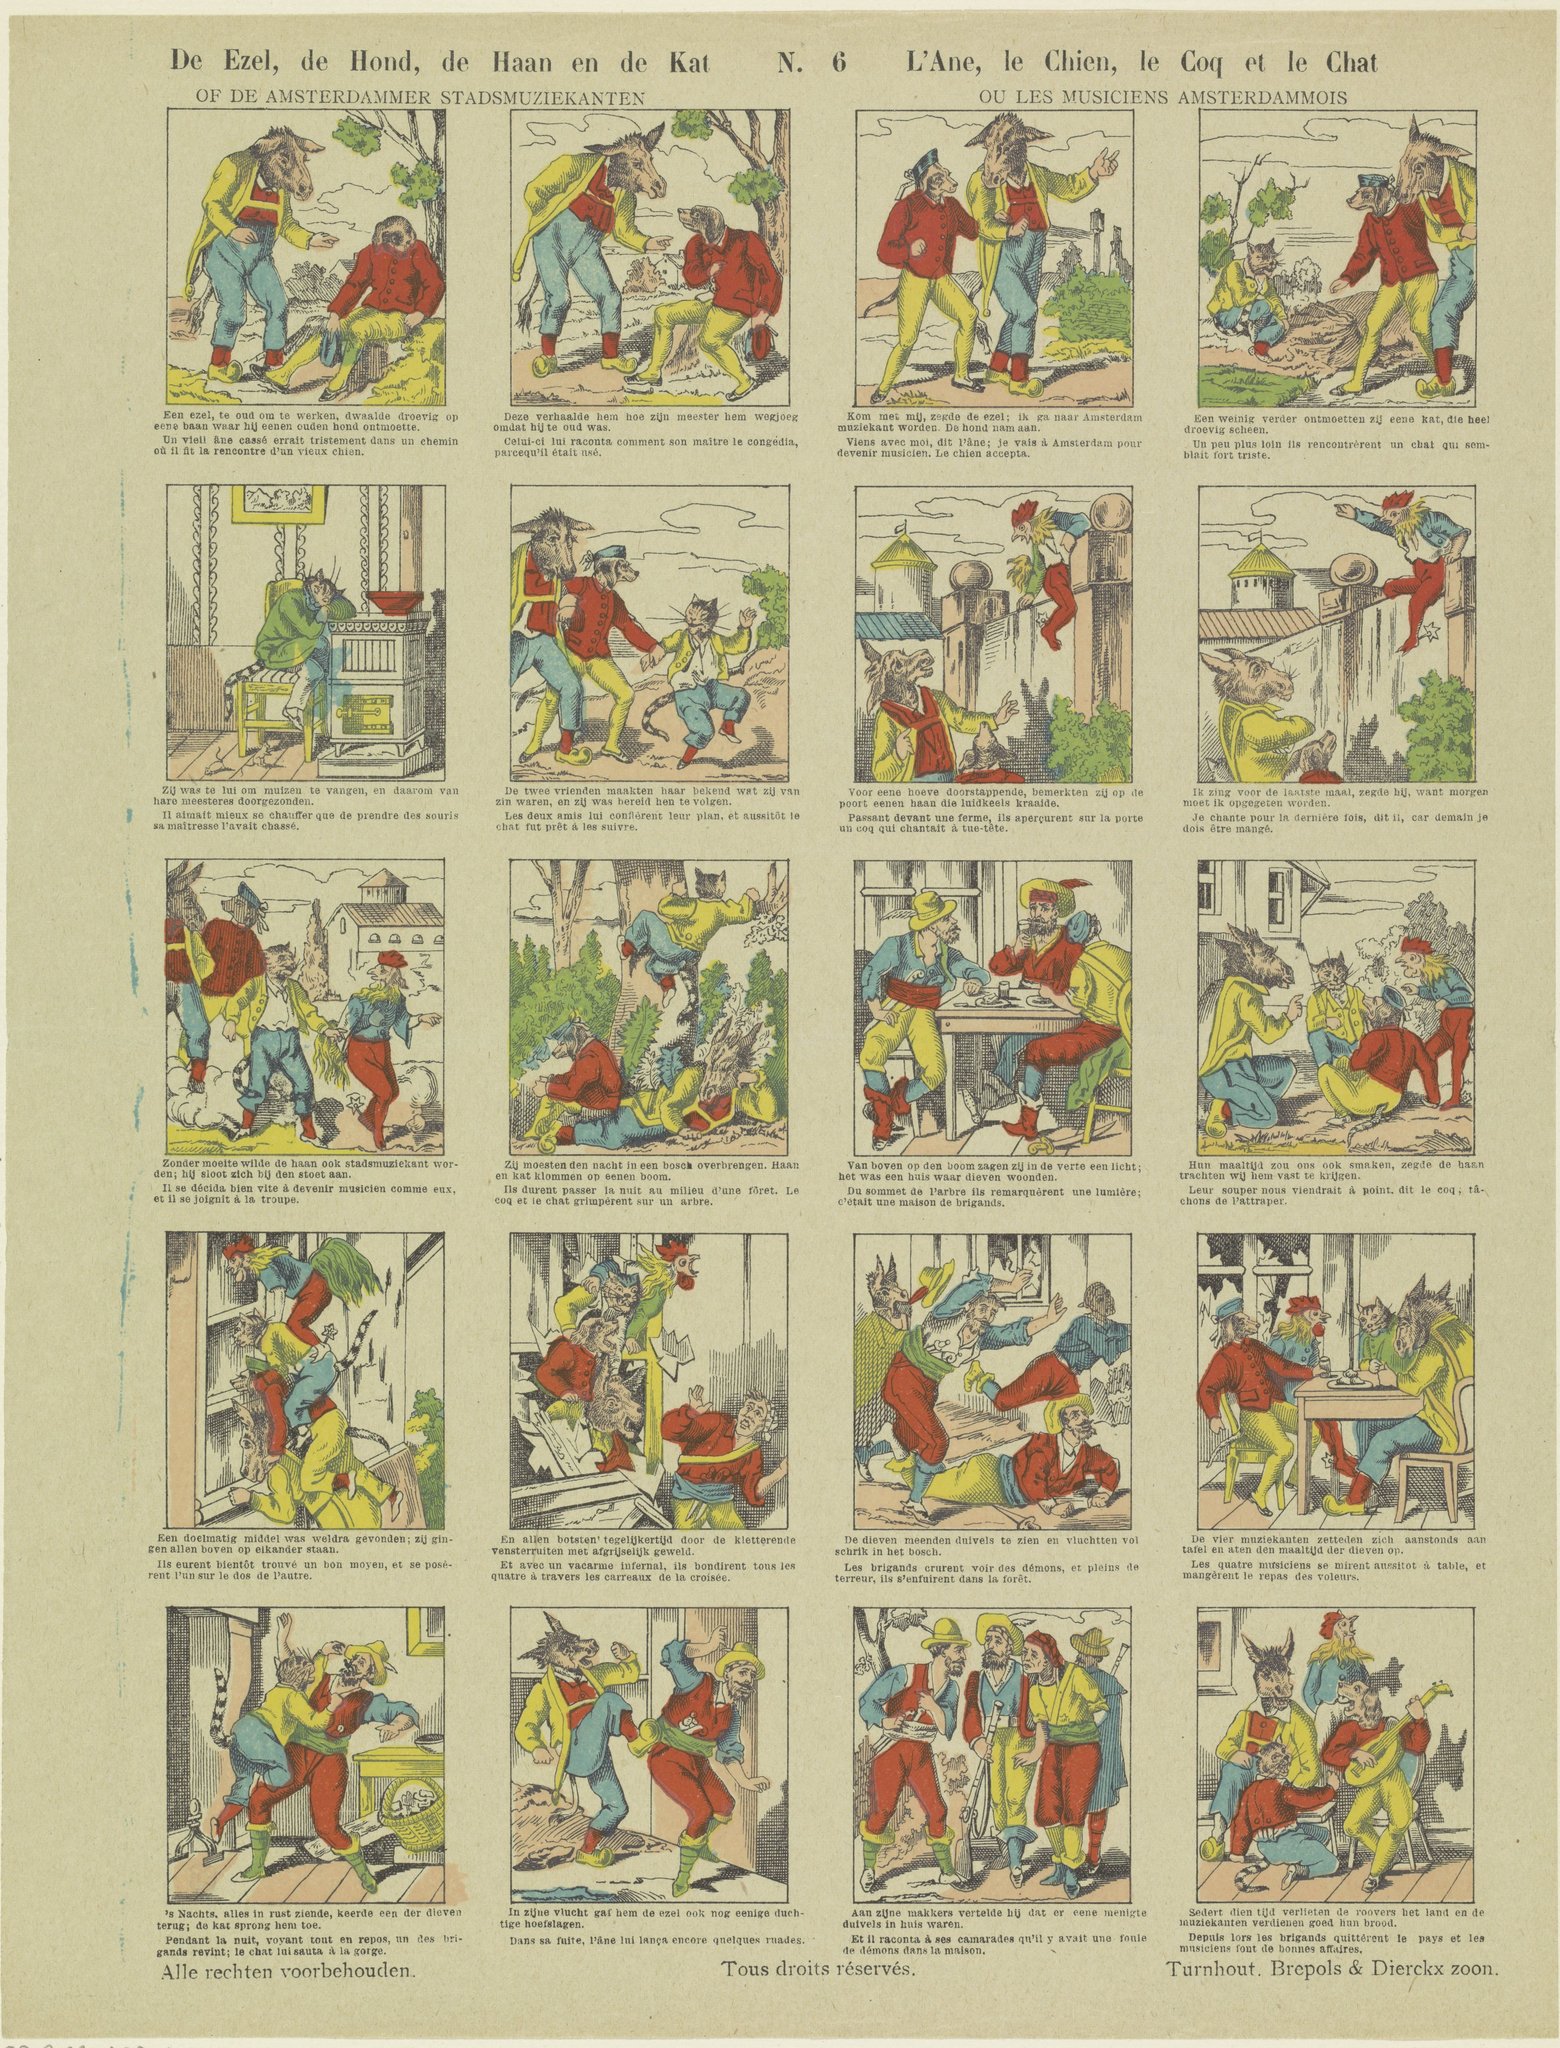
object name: popular print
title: De ezel, de hond, de haan en de kat / Of de Amsterdammer stadsmuziekanten / L'ane, le chien, le coq et le chat / Ou les musiciens Amsterdammois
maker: Anonymous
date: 1833-1911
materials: paper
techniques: lithograph, letterpress printing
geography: turnhout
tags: cat, ass, donkey, fowl (cock, hen, chicken, etc.), tales and fairy tales, dog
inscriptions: collector's mark: Lugt 2760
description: Blad met 20 voorstellingen uit het sprookje van de ezel, de hond, de haan en de kat: de Amsterdammer stadsmuzikanten. Onder elke afbeelding een onderschrift in het Nederlands en in het Frans. Genummerd midden boven: N. 6.